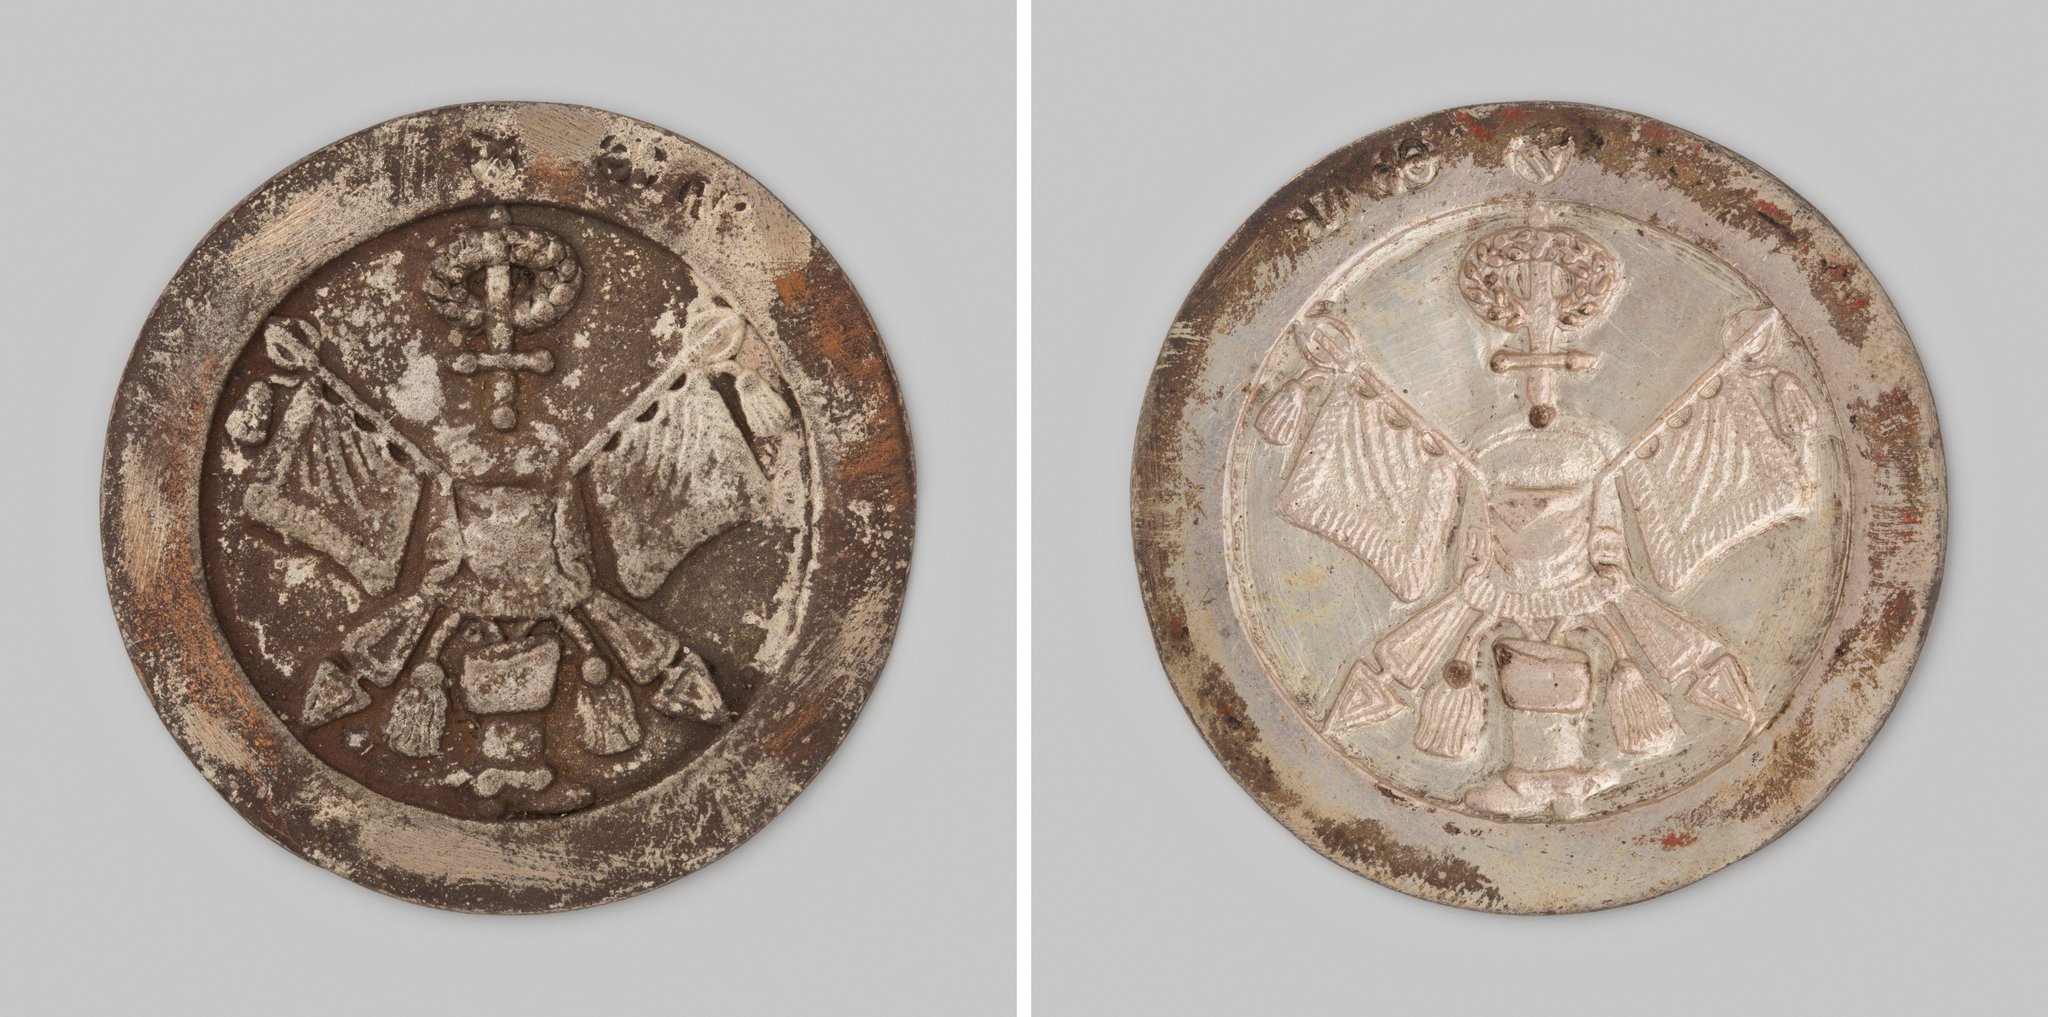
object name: history medal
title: Erepenning voor de Borger Cavalerie te Batavia (keerzijde) 1727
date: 1727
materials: copper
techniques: galvanoplasty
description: Verzilverde galvanoplastische afdruk van de keerzijde van de penning, twee gekruisde pieken met vanen, een patroontas en een laars waarboven een zwaard met krans.